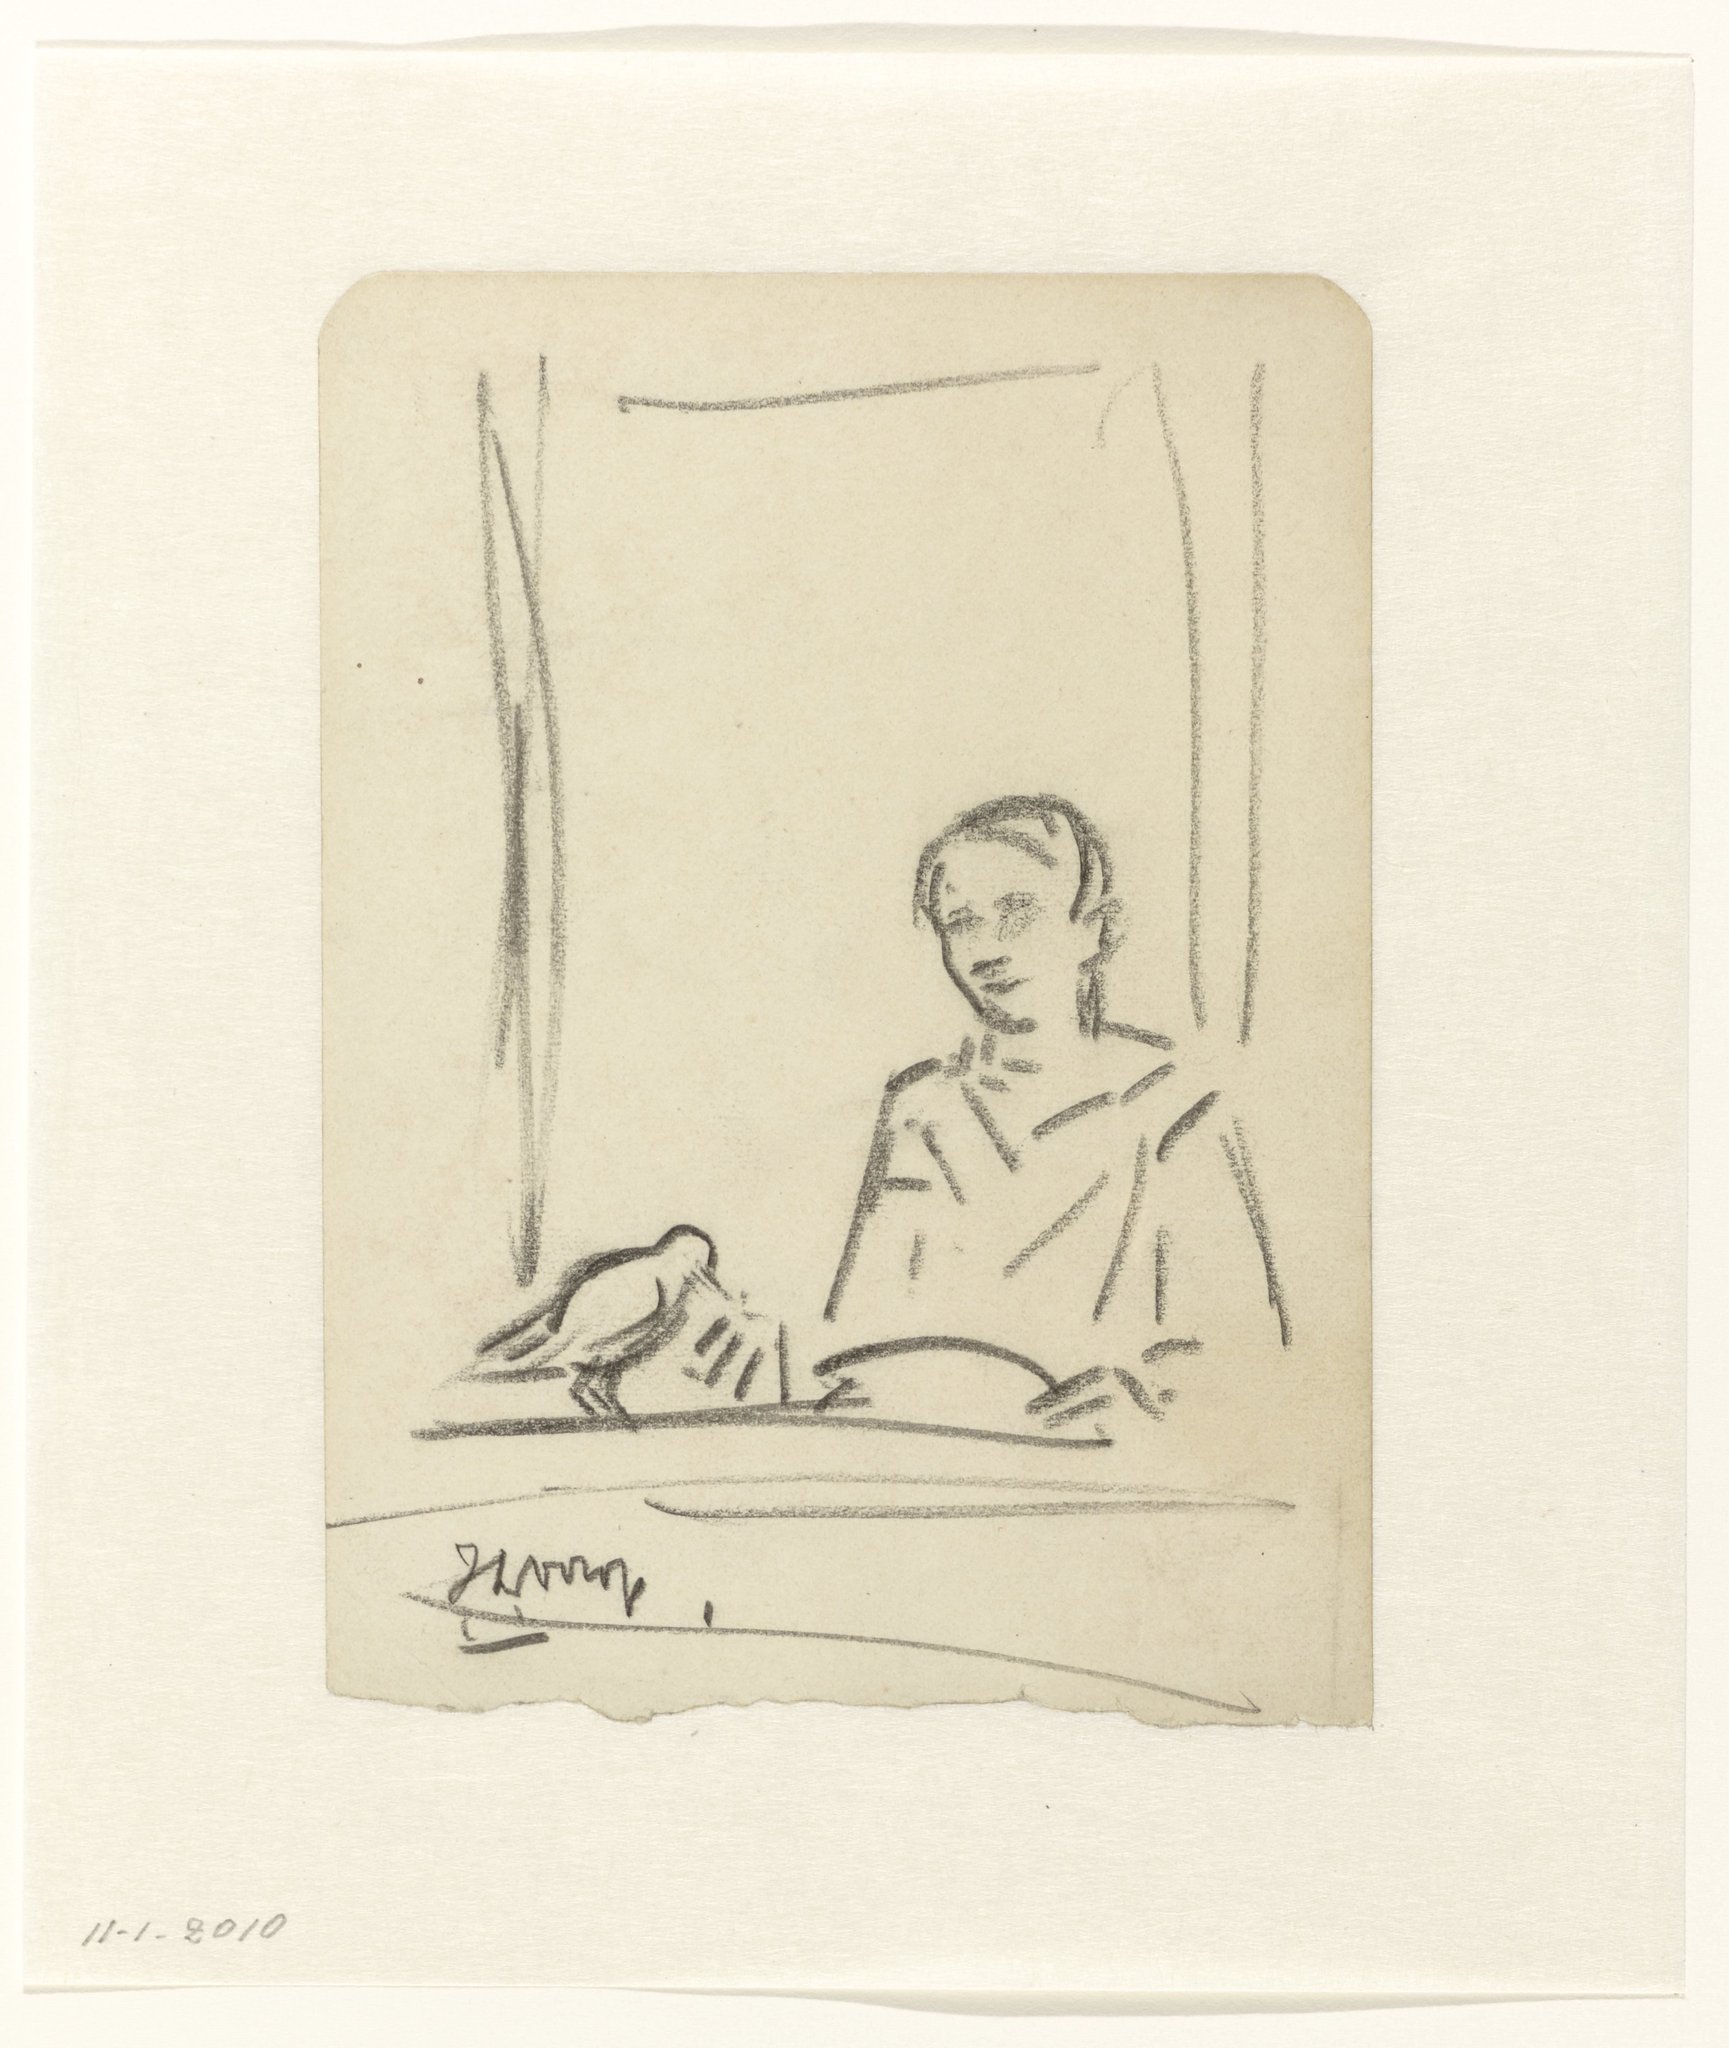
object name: drawing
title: Meisje met vogel in het venster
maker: jan toorop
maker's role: draughtsman, painter, print maker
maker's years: 1858-1928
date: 1868-1928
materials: chalk, paper